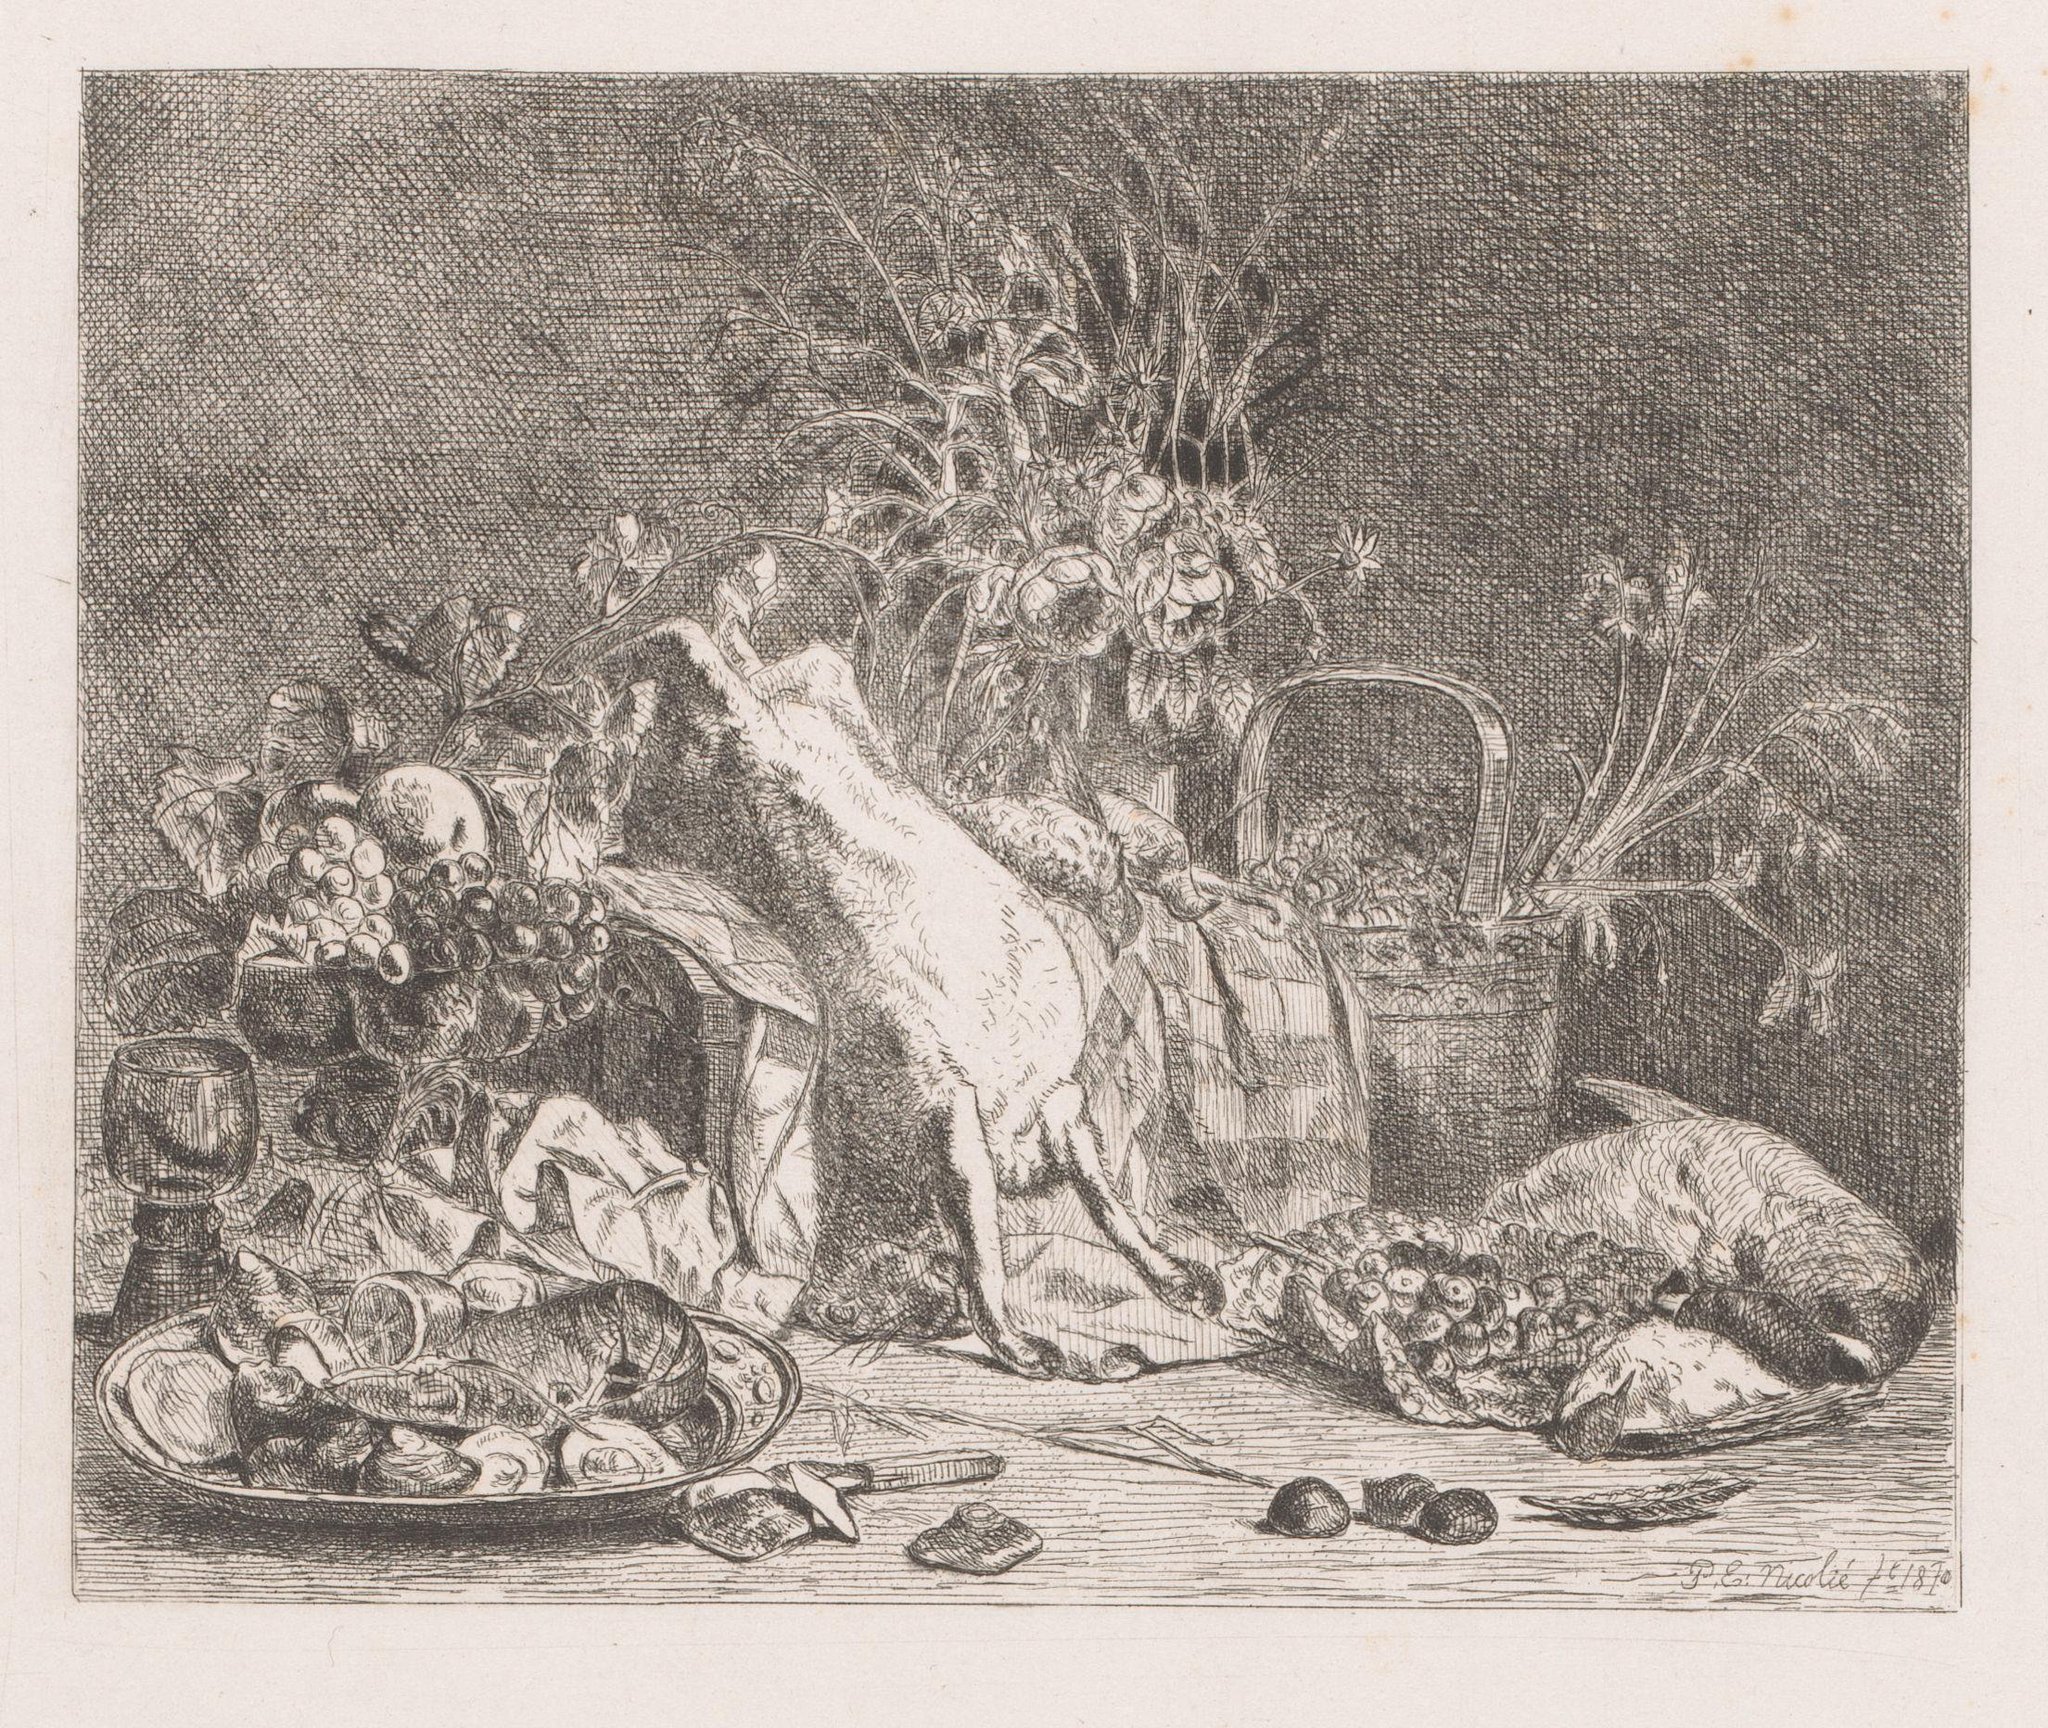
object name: print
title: Stilleven van bloemen, vruchten en wild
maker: paul emile nicolié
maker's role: print maker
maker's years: 1828-1894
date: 1870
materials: paper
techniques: etching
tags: rodents: hare, still life of plants, flowers and fruit, foodstuffs; still life of foodstuffs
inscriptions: collector's mark: Lugt 2228